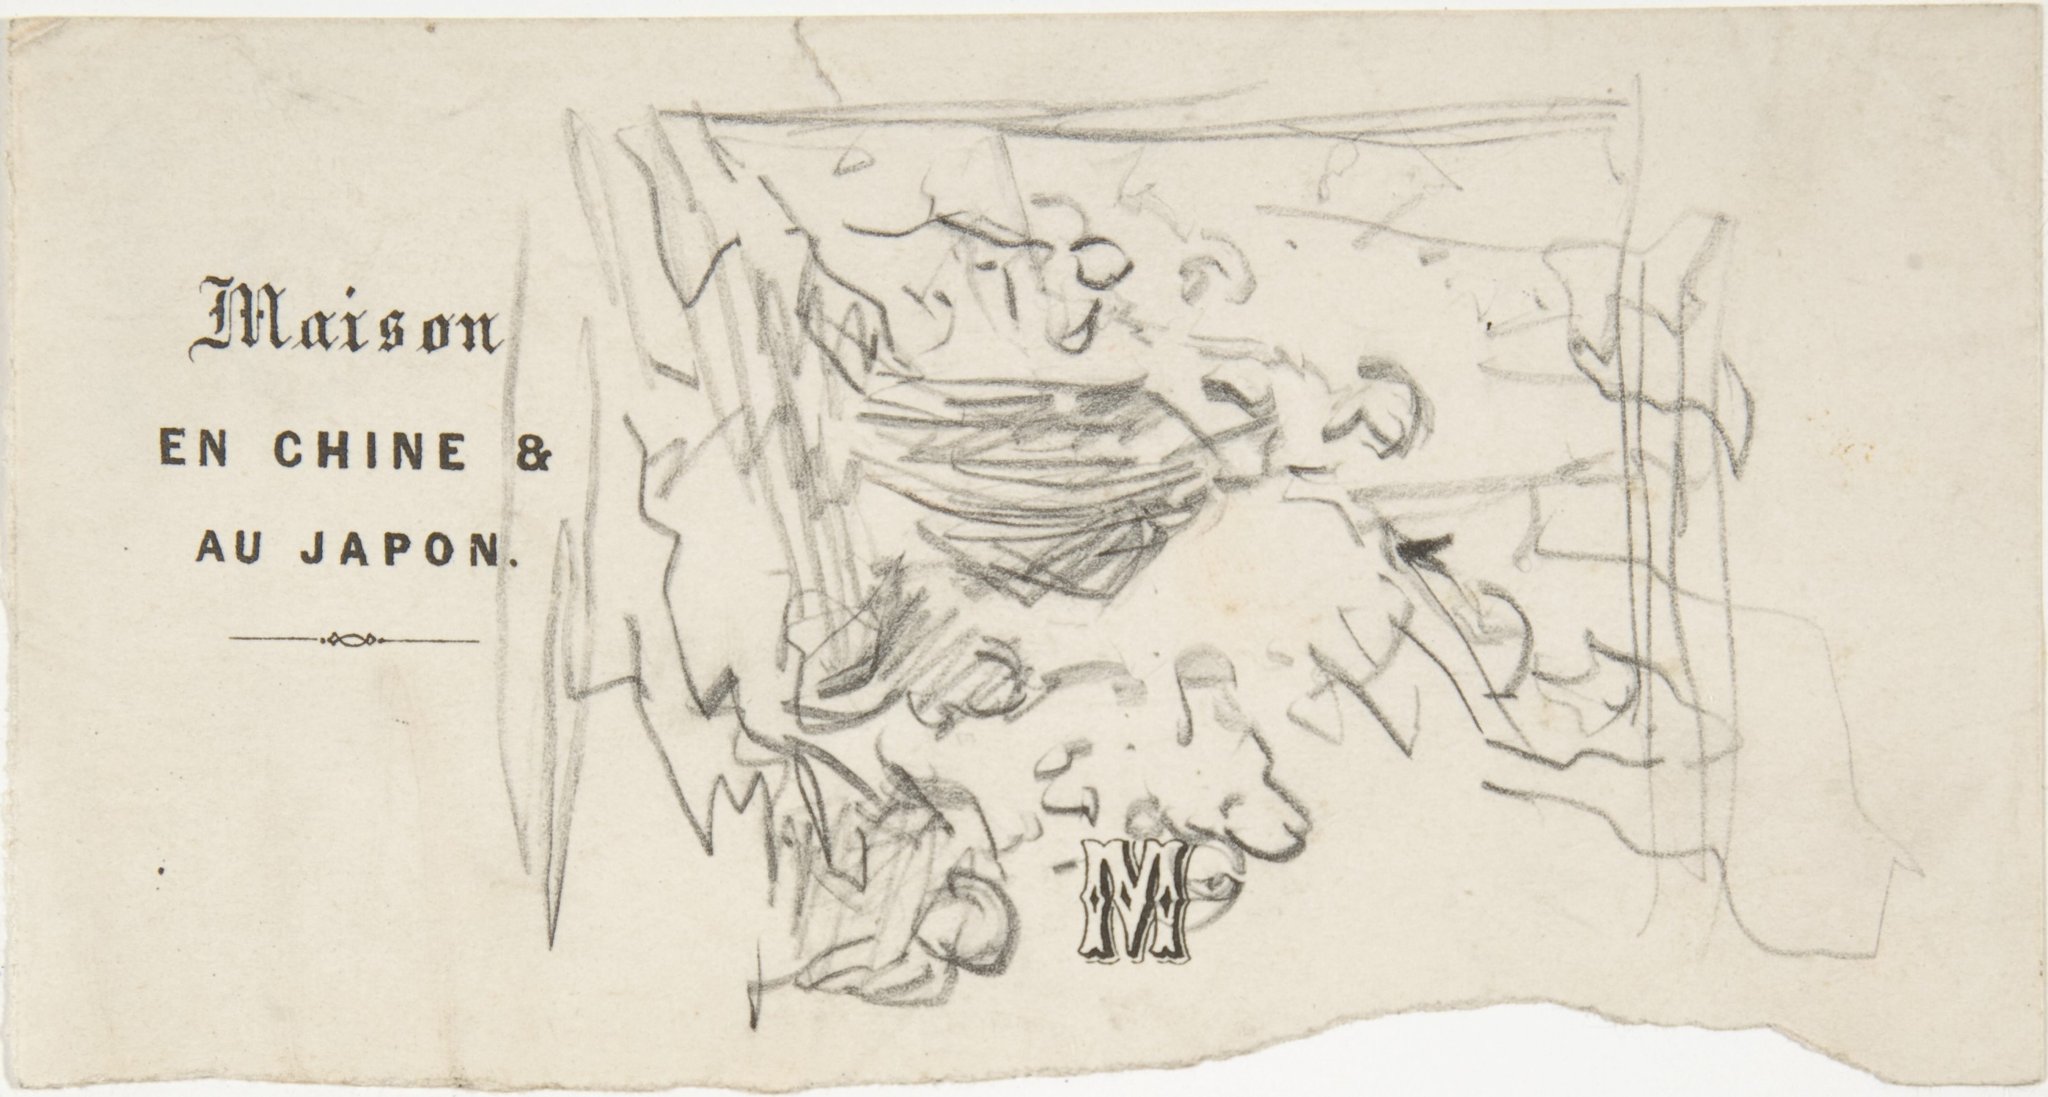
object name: drawing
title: Figure composition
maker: narcisse-virgile diaz de la peña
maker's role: artist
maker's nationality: french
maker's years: 1808-1876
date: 1820-1876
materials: chalk, paper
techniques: printing